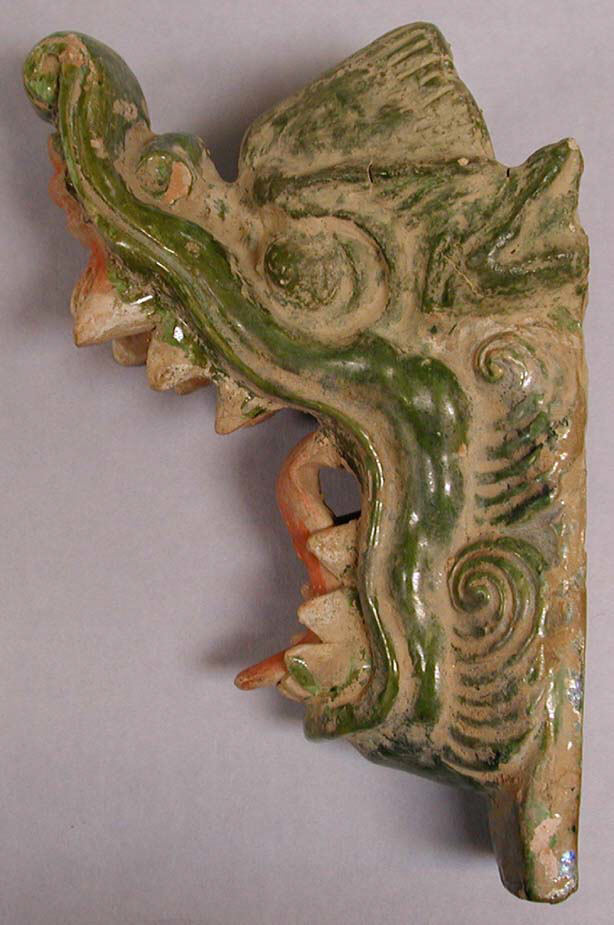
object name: ornament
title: Dragon head with open mouth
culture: chinese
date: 907-1125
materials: glaze, stoneware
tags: dragons